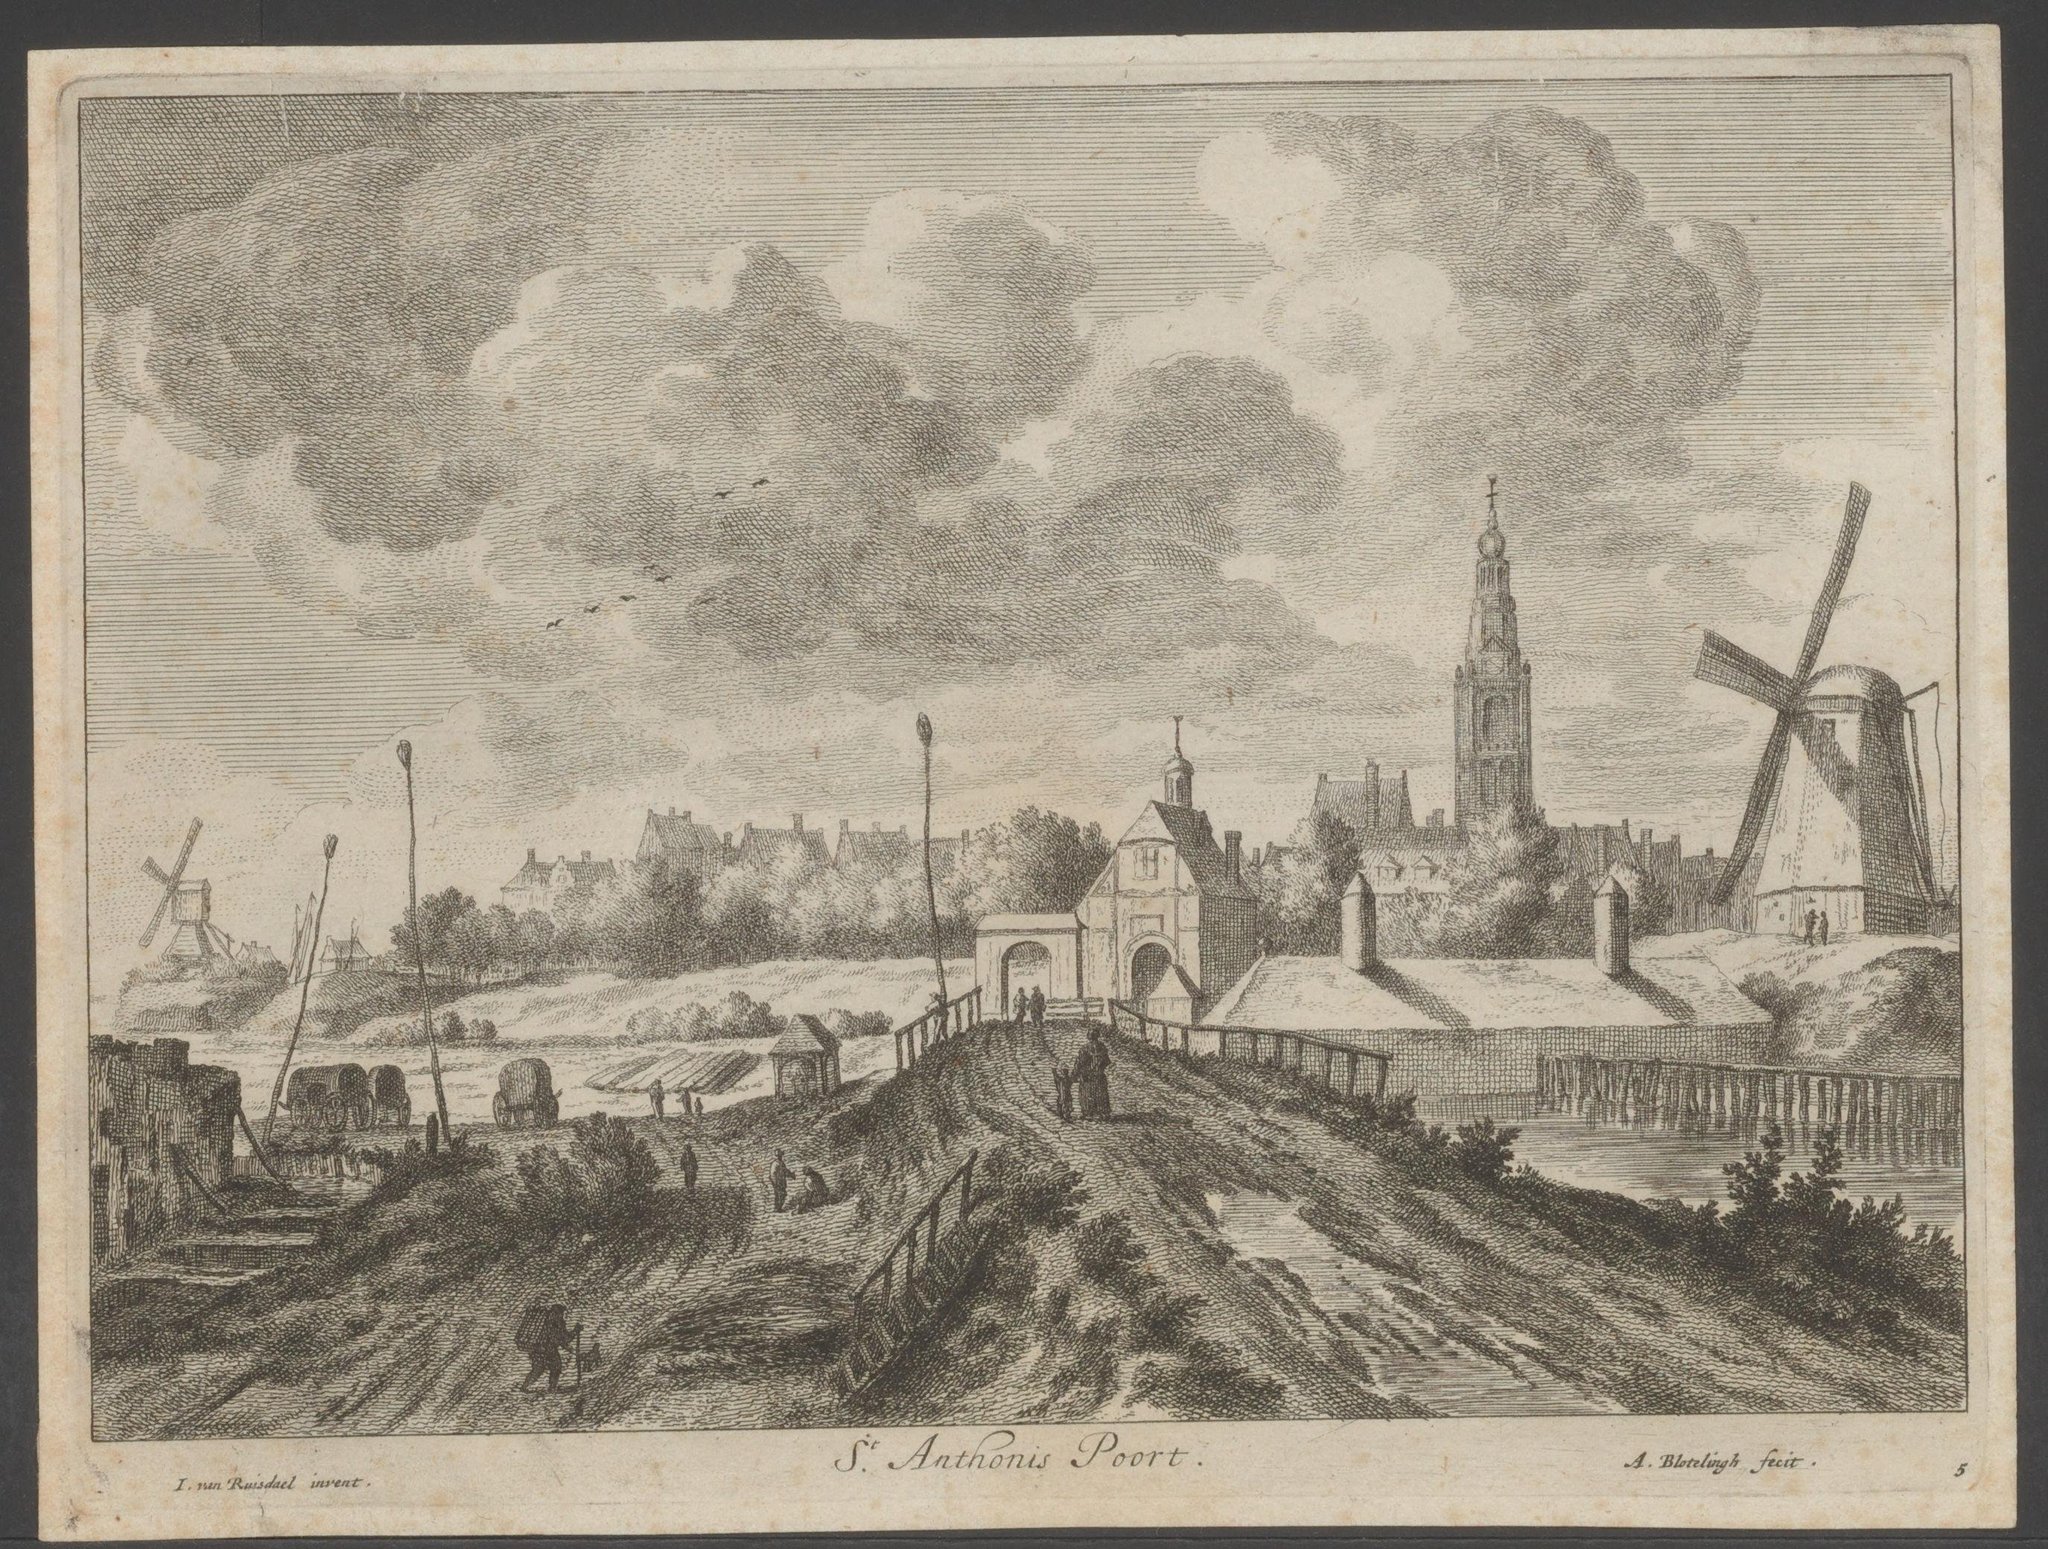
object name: print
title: St. Anthonis Poort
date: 1655-1690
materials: paper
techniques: engraving, etching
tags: windmill in landscape, city-gate, parts of church exterior and annexes: tower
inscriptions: collector's mark: Lugt 1641b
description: Rechtsonder genummerd: 5. Onderwerpsrubriek binnen de Atlas Amsterdam: Poorten, verzamelbladen, C. St. Antoniespoort.